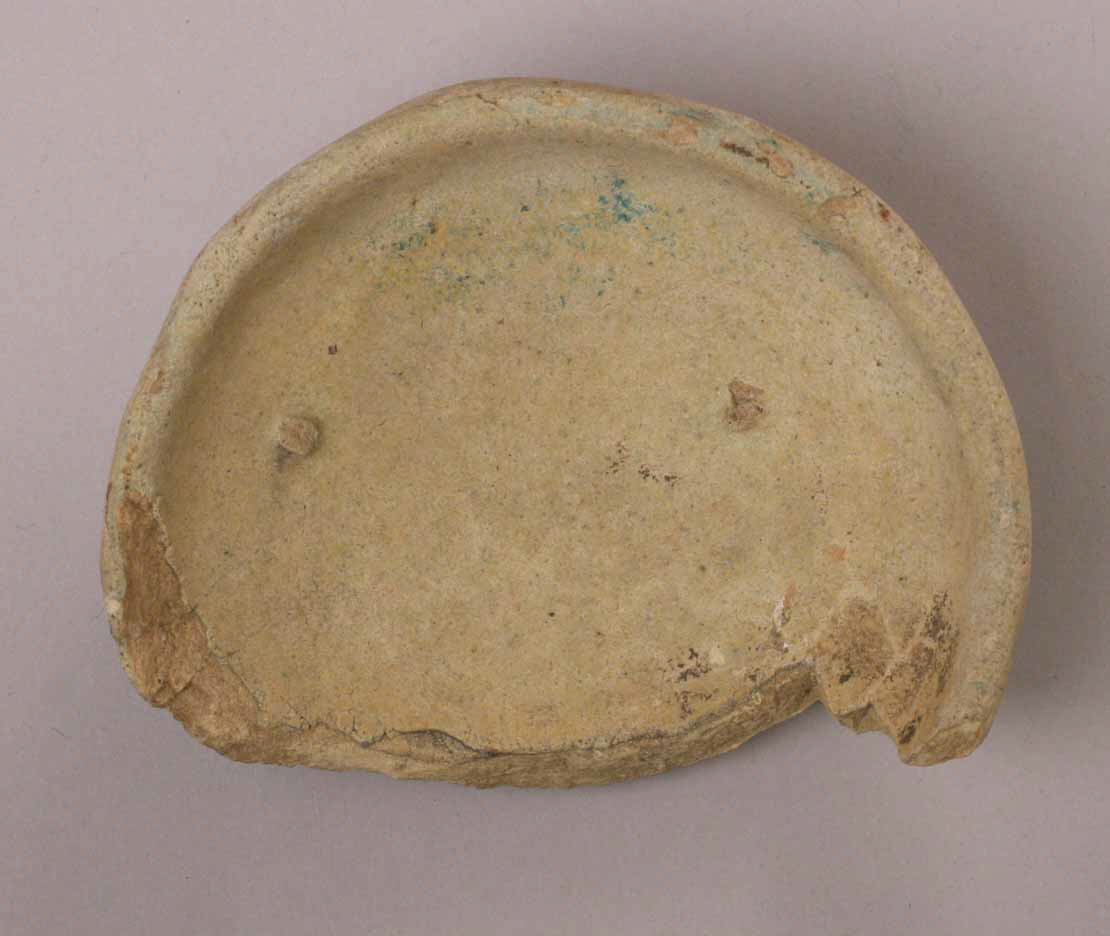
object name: fragment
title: Ceramic Fragment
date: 201-700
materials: earthenware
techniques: glazing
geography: iraq